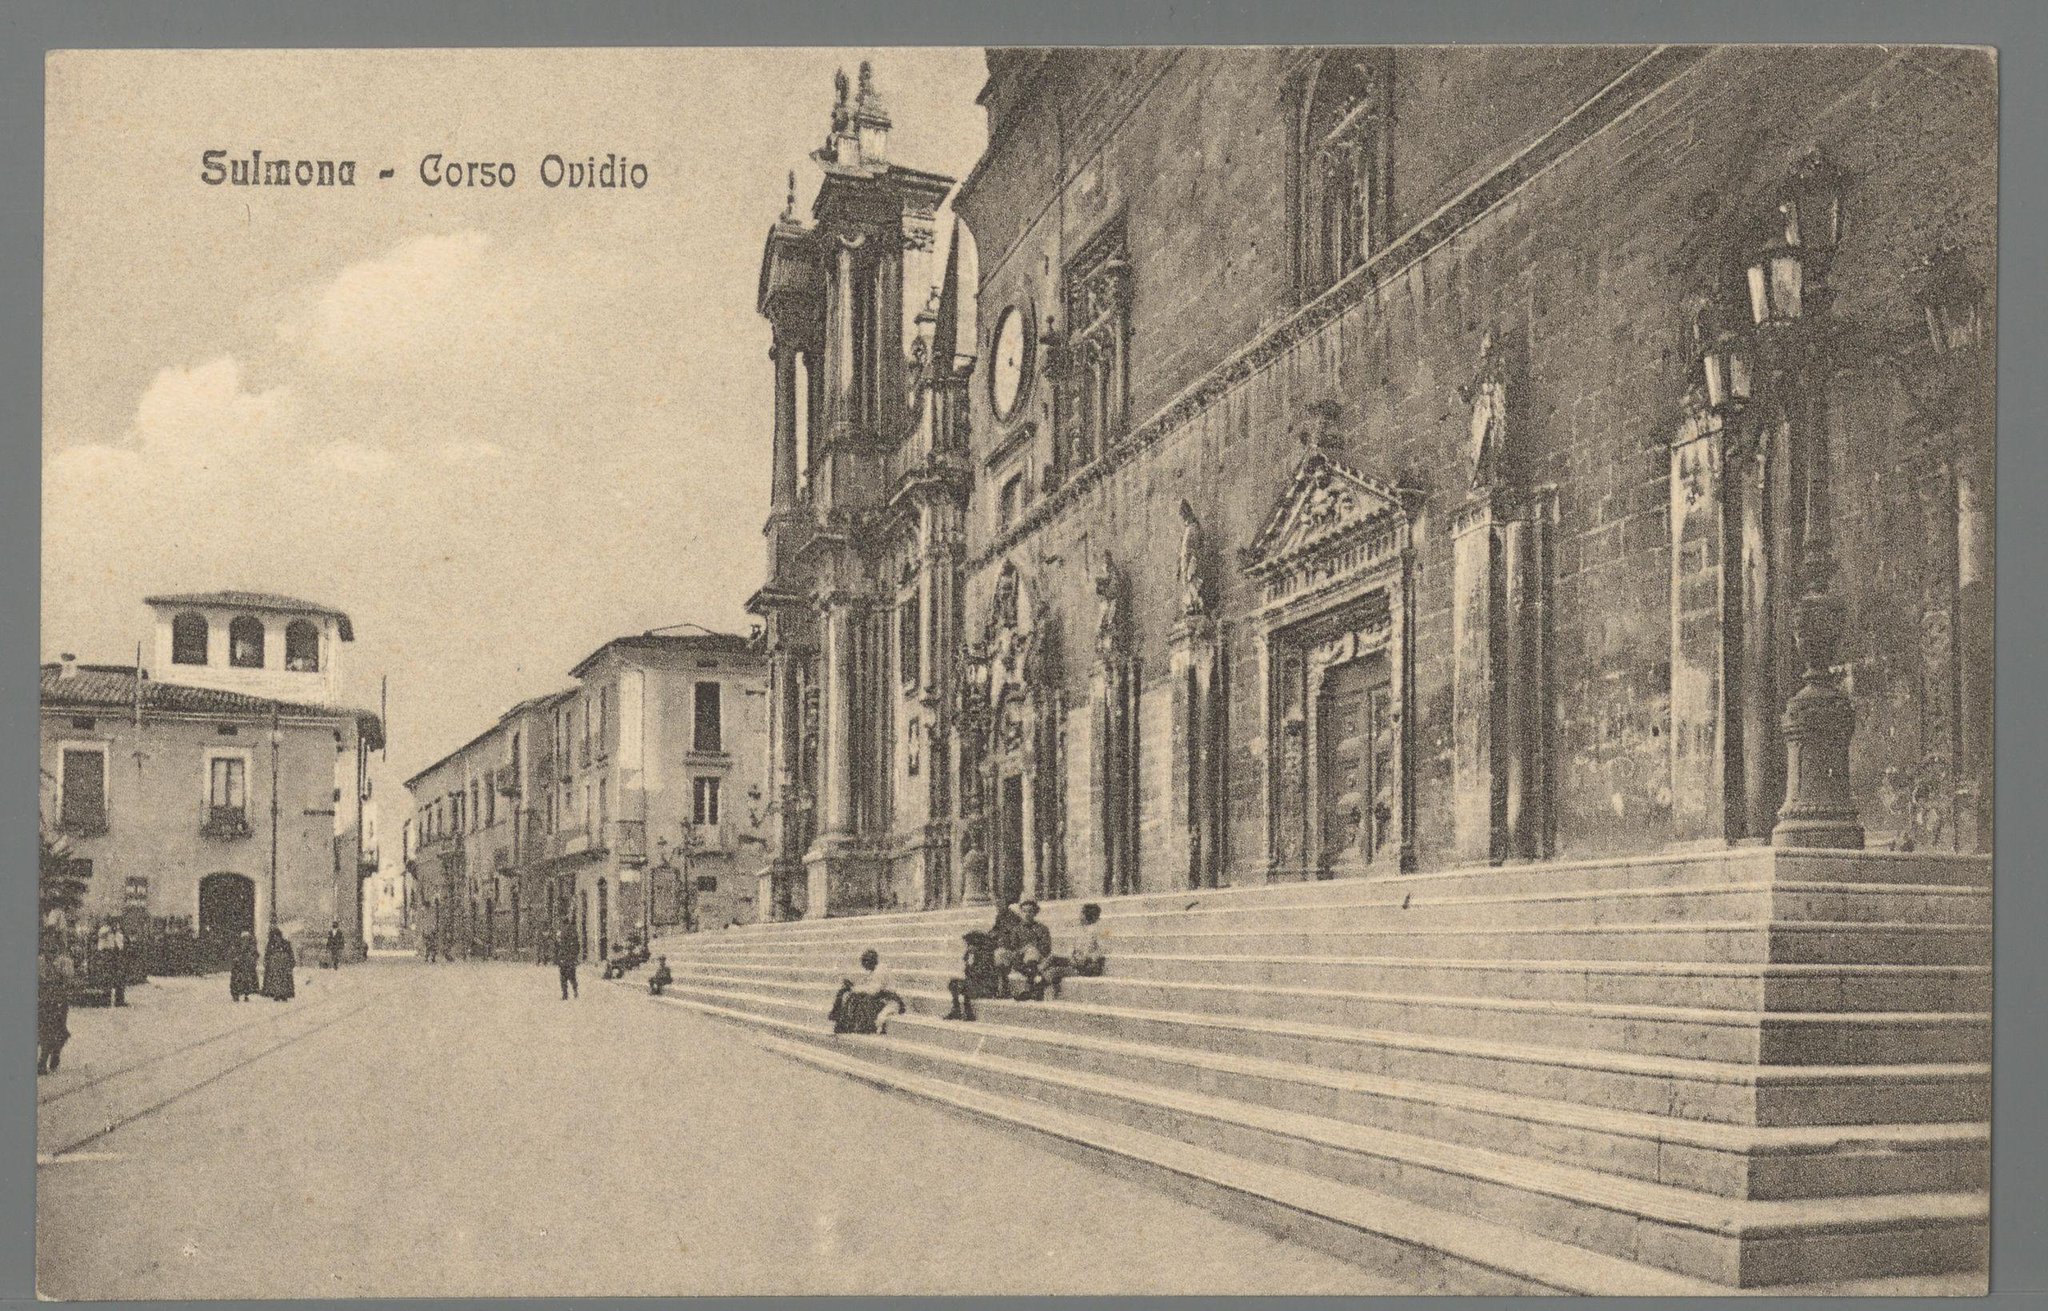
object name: ansichtkaart, prentbriefkaart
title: Sulmona. Corso Ovidio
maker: Anonymous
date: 1906-1920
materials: cardboard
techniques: photograph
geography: sulmona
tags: church (exterior), square, place, circus, etc. (+ city(-scape) with figures, staffage)